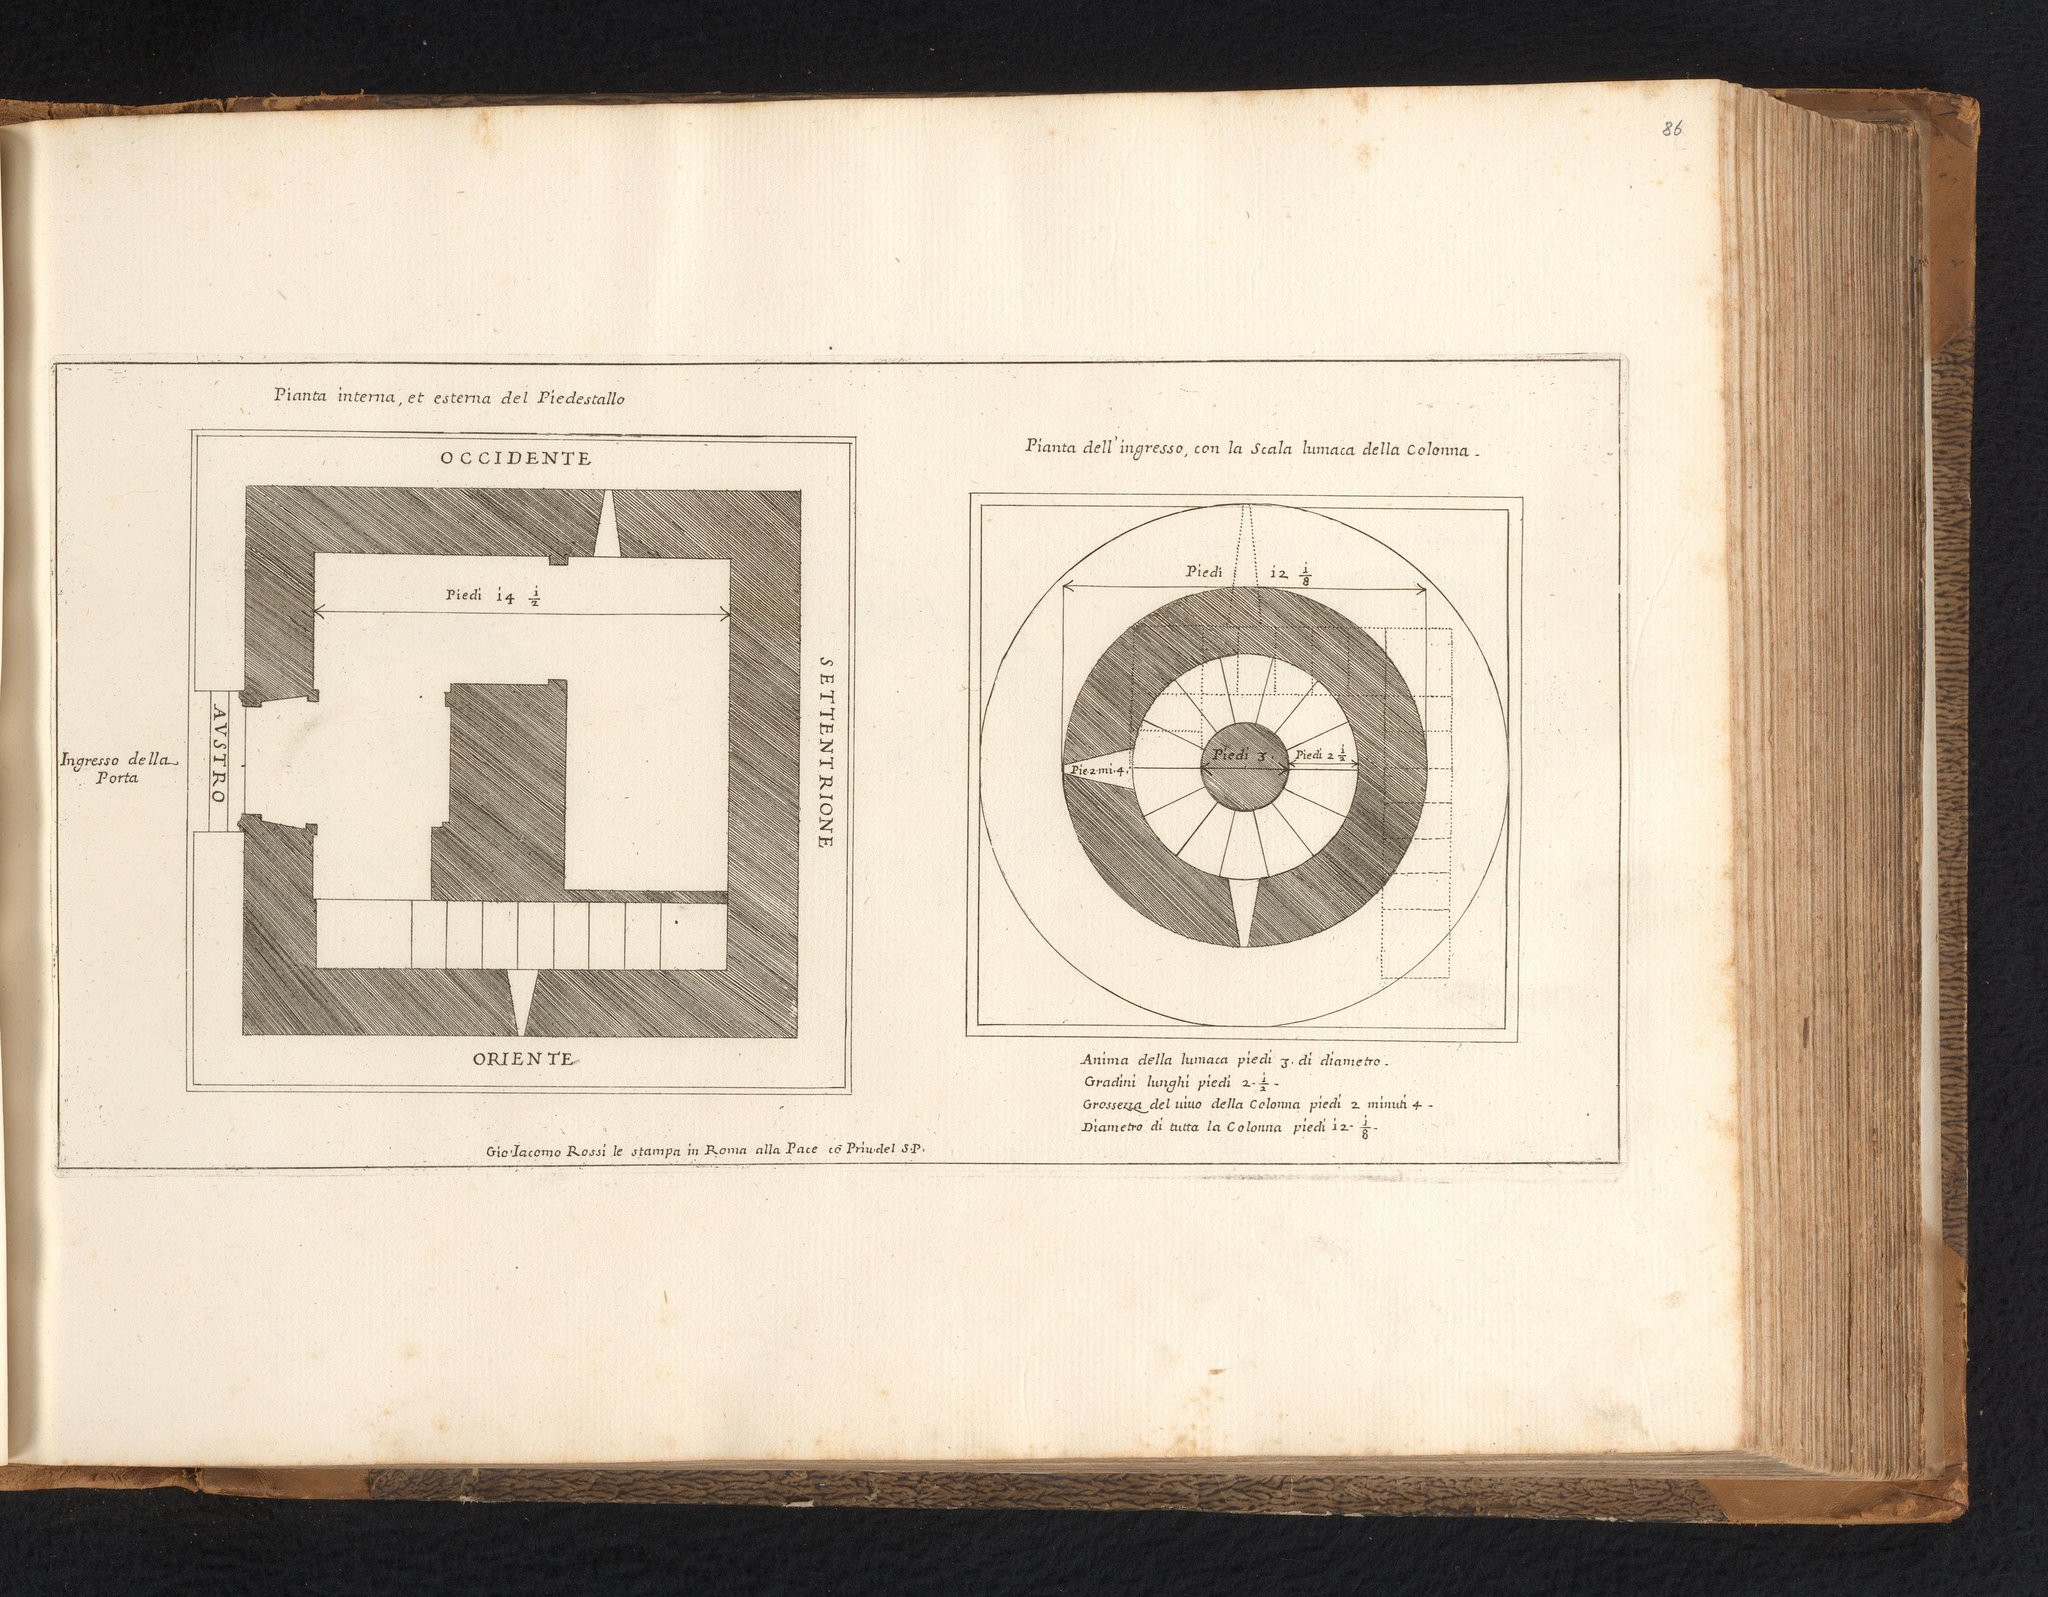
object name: album leaf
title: Colonna Traiana eretta dal senato, e popolo Romano all' imperatore Traiano Augusto nel suo foro in Rom (...)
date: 1637-1691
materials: paper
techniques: etching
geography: france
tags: triumphal column with helical friezes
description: Deze prent maakt deel uit van een reeks van 128 prenten(+ titelprent) (alleen de 119 prenten met details van het grote fries zijn genummerd) met voorstellingen van de Zuil van Trajanus.